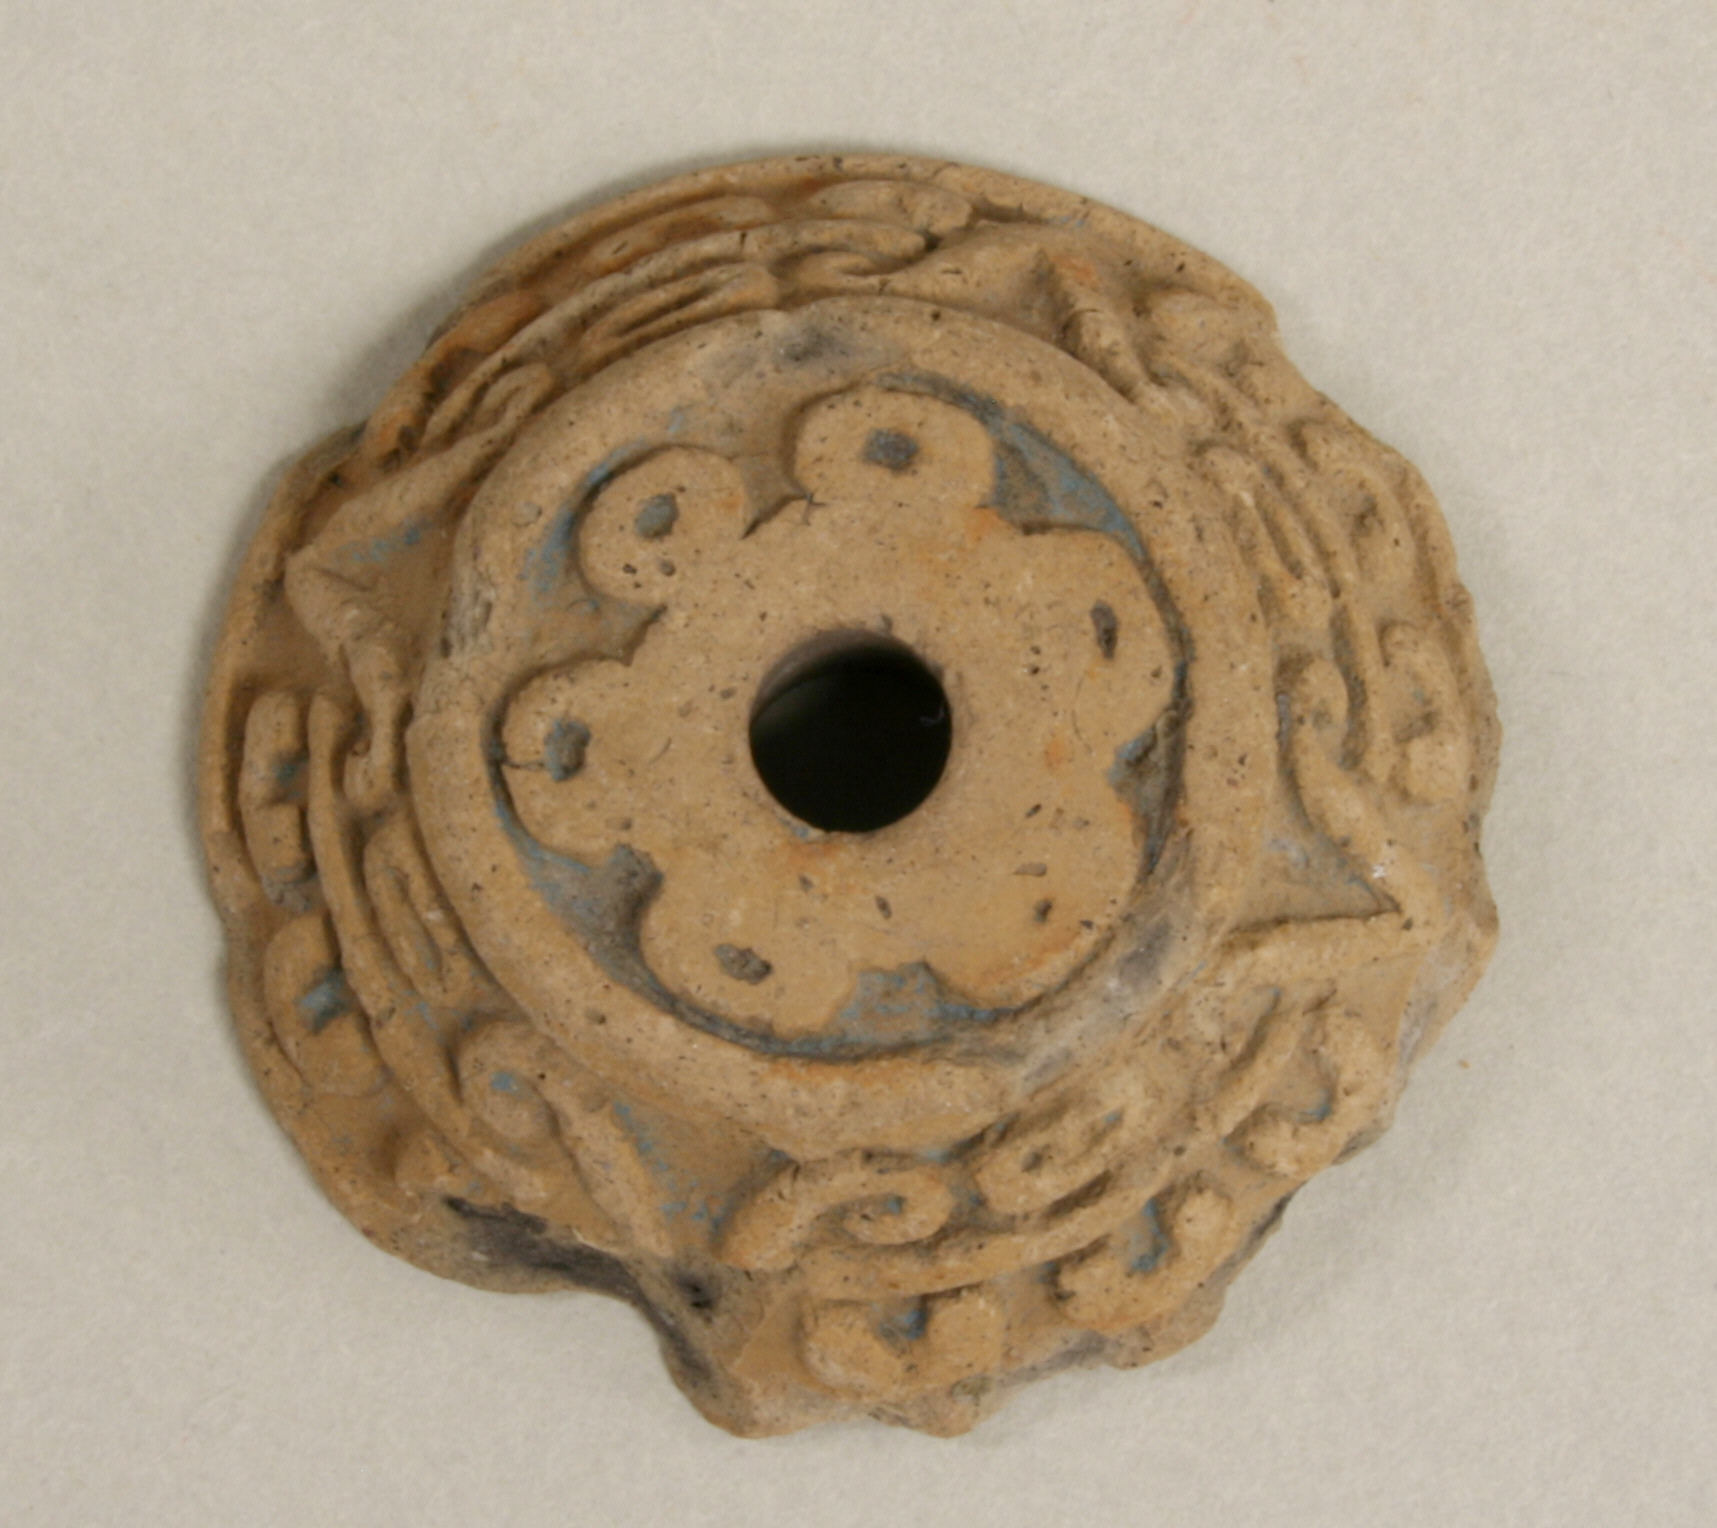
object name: spindle whorl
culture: mexican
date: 801-1500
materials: ceramic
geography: mexico